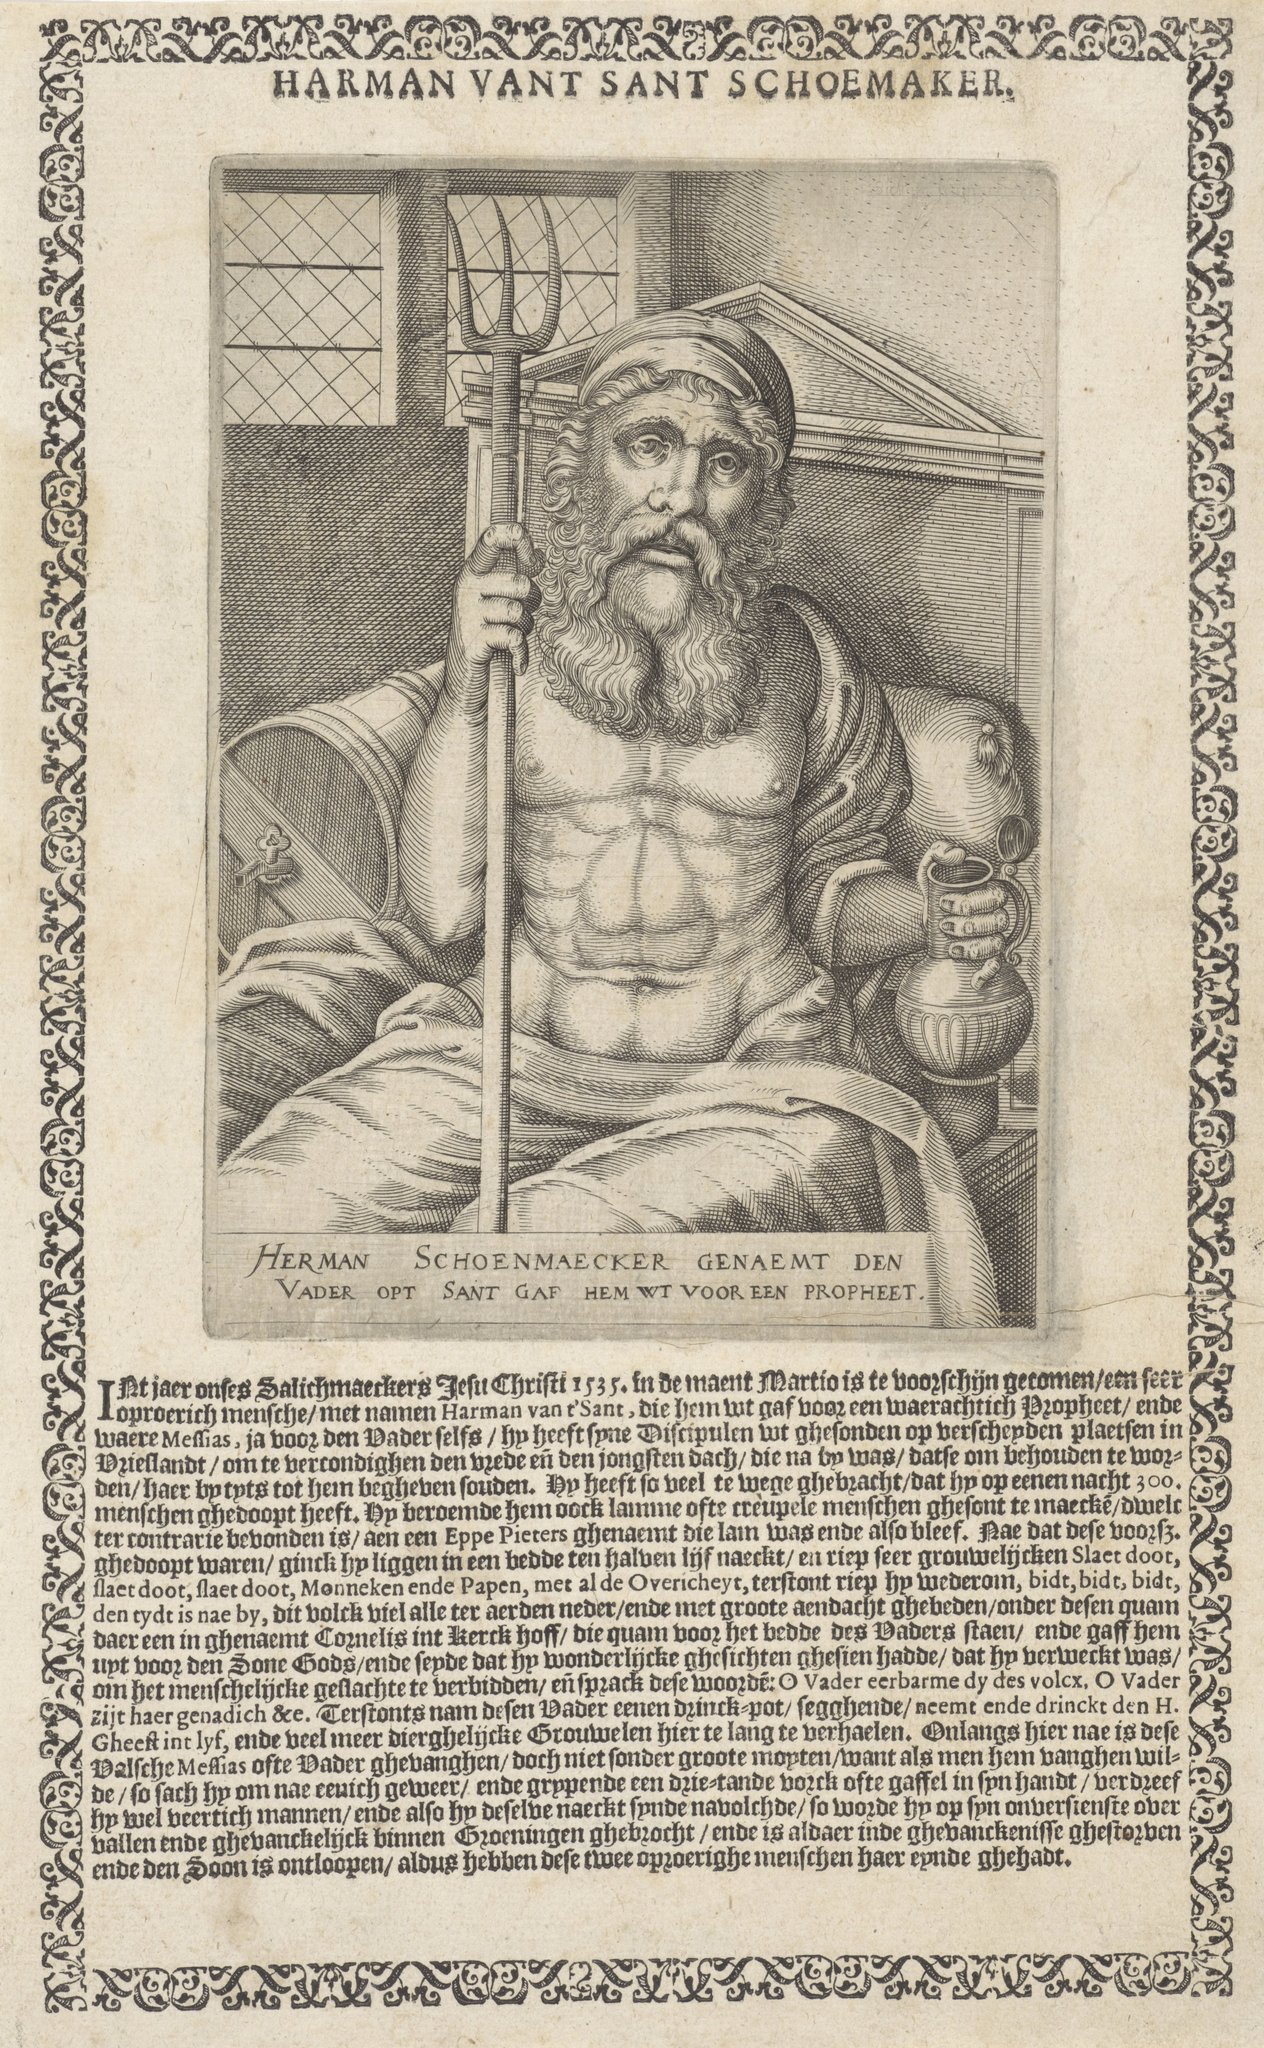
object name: print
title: Herman Schoenmaecker genaemt den Vader opt Sant gaf hem uut voor een propheet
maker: christoffel van sichem (i)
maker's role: print maker, publisher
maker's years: 1546-1624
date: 1608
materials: paper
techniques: engraving, letterpress printing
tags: historical persons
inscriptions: collector's mark: Lugt 2228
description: Portret van de zelfverklaarde profeet Hermannus de Schoenmaker, halfnaakt in bed. In zijn hand houdt hij een drietand, in de andere hand een kruik. Naast het bed staat een wijnvat. Boven en onder de prent een Nederlandstalige tekst in boekdruk met verklaring van het optreden van De Schoenmaker in 1535, waarbij hij vanuit bed voor het volk preekte. Rondom een ornamentele omlijsting.